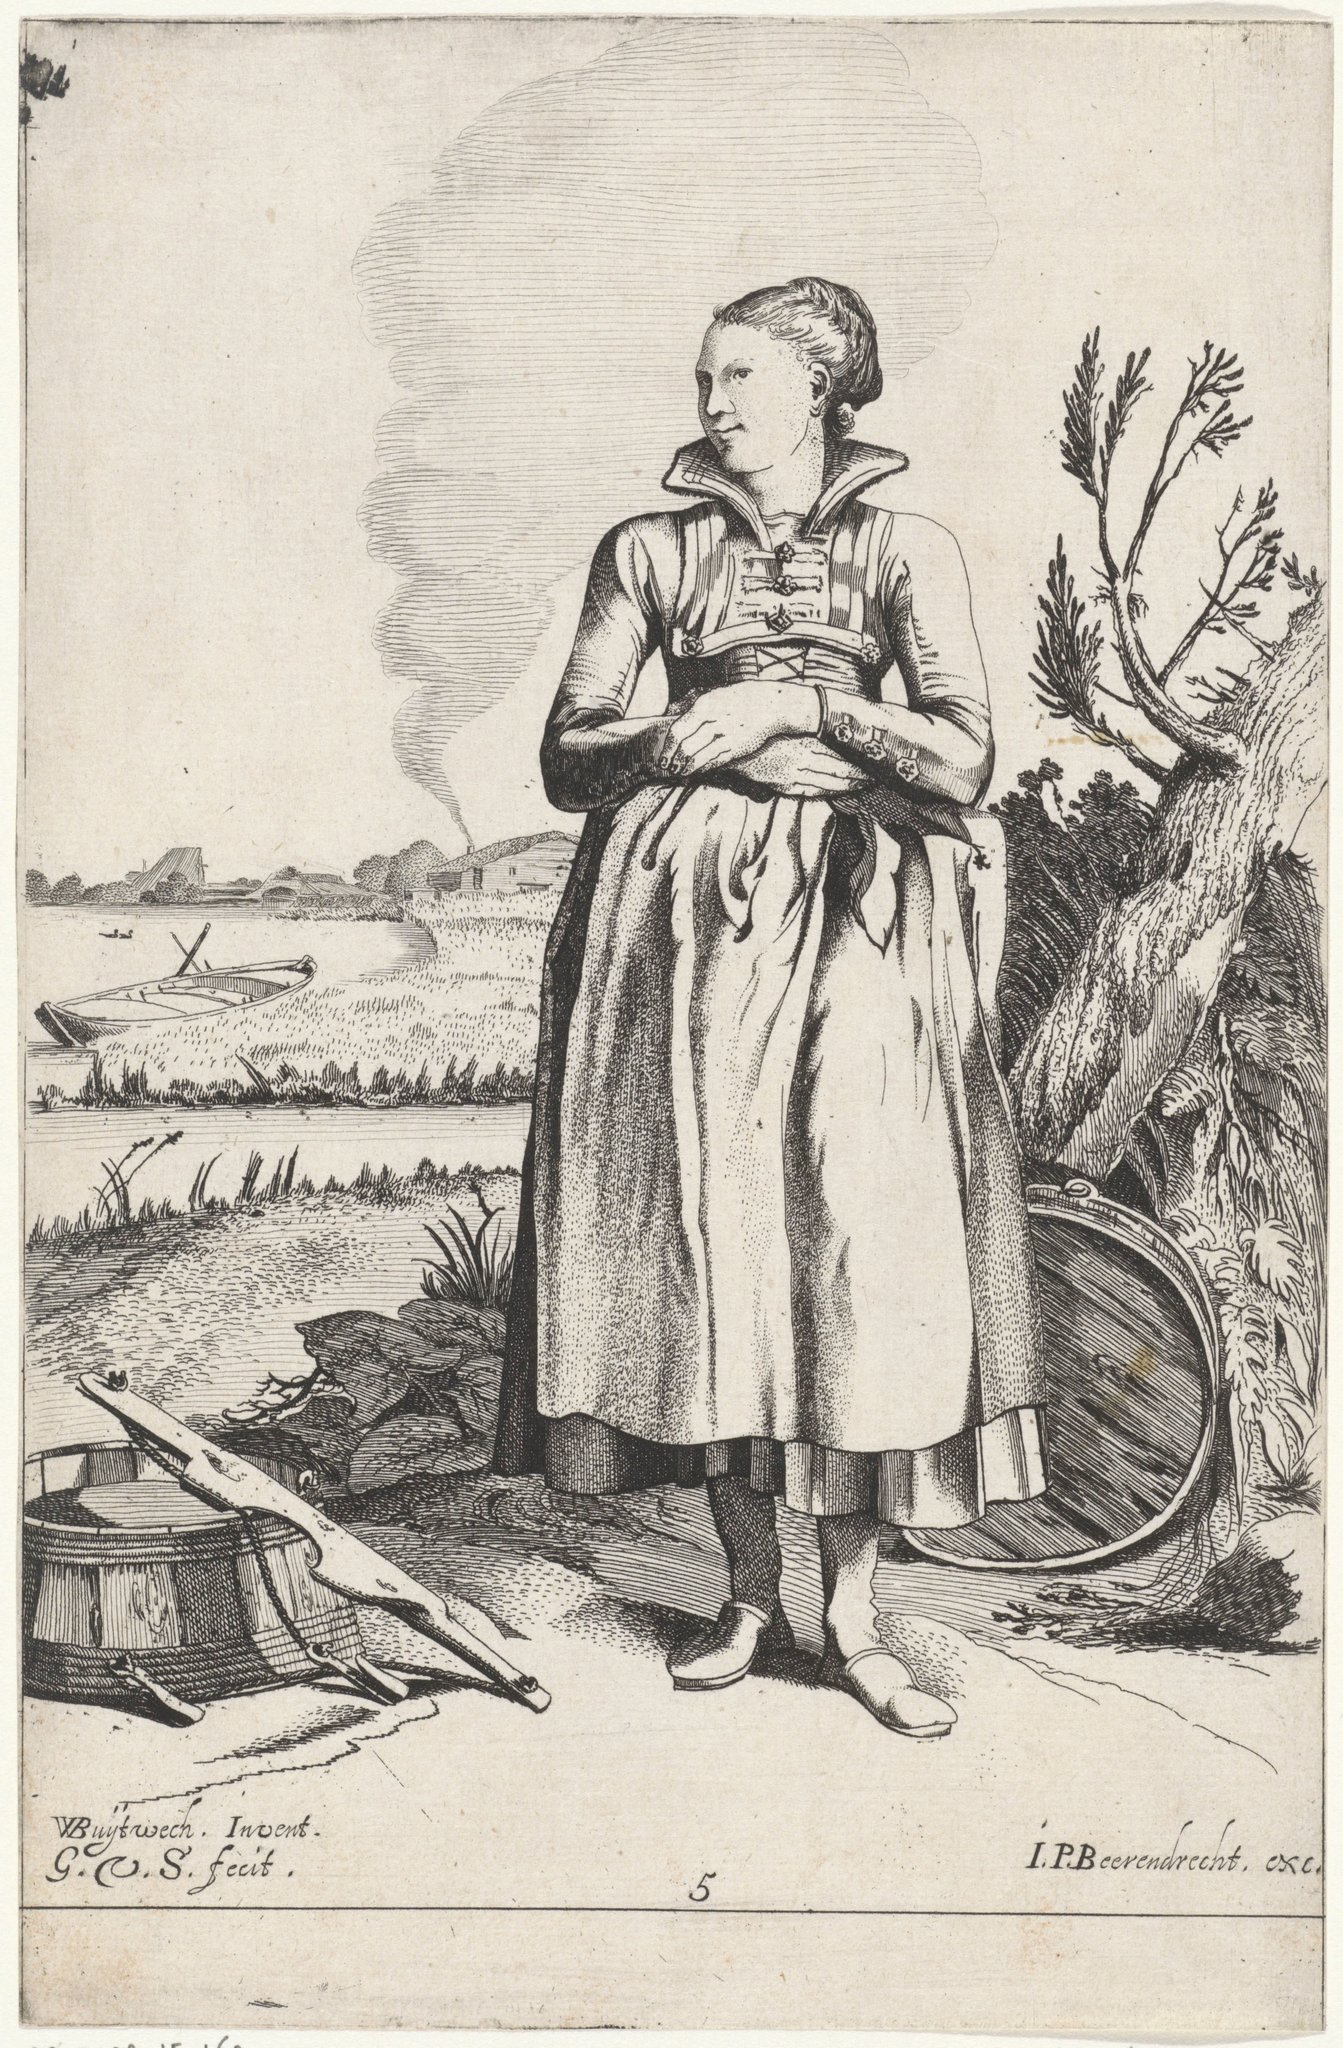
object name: print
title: Noord-Hollandse klederdrachten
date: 1620-1624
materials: paper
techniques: etching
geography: haarlem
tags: folk costume, regional costume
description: In een vlak landschap met kanalen staat een jonge vrouw uit Edam, gekleed in klederdracht. Naast haar liggen een juk en een emmer. Op de achtergrond een boerenhoeve. De prent maakt deel uit van een serie van acht jonge vrouwen in Noord-Hollandse klederdrachten.